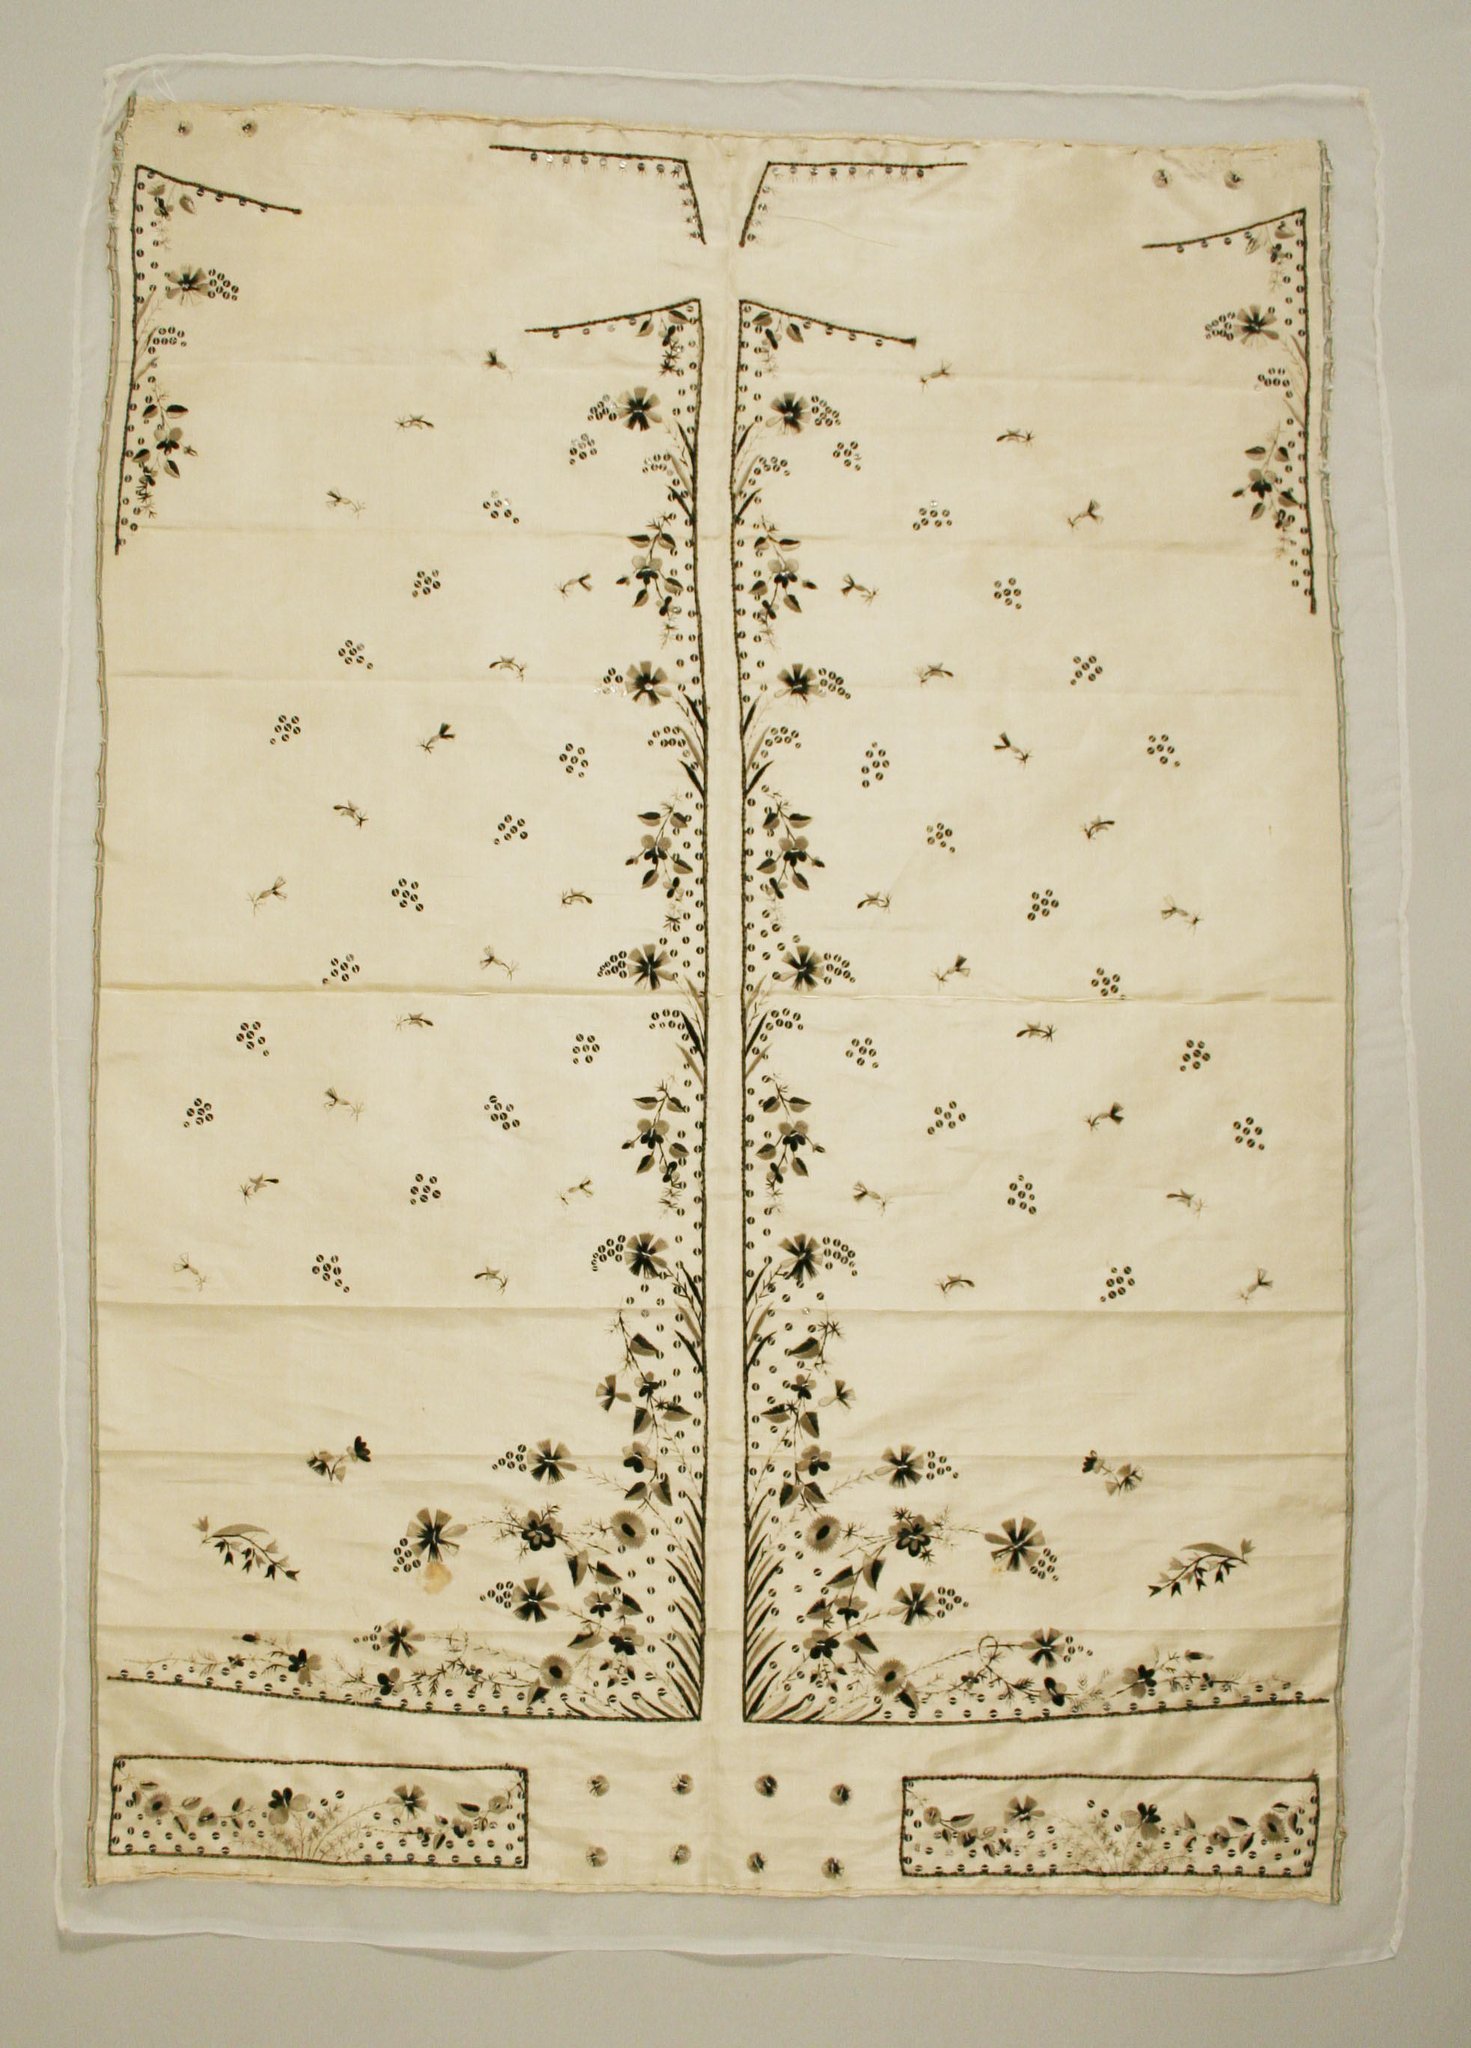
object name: waistcoat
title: Waistcoat panel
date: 1701-1800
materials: metal, silk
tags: flowers